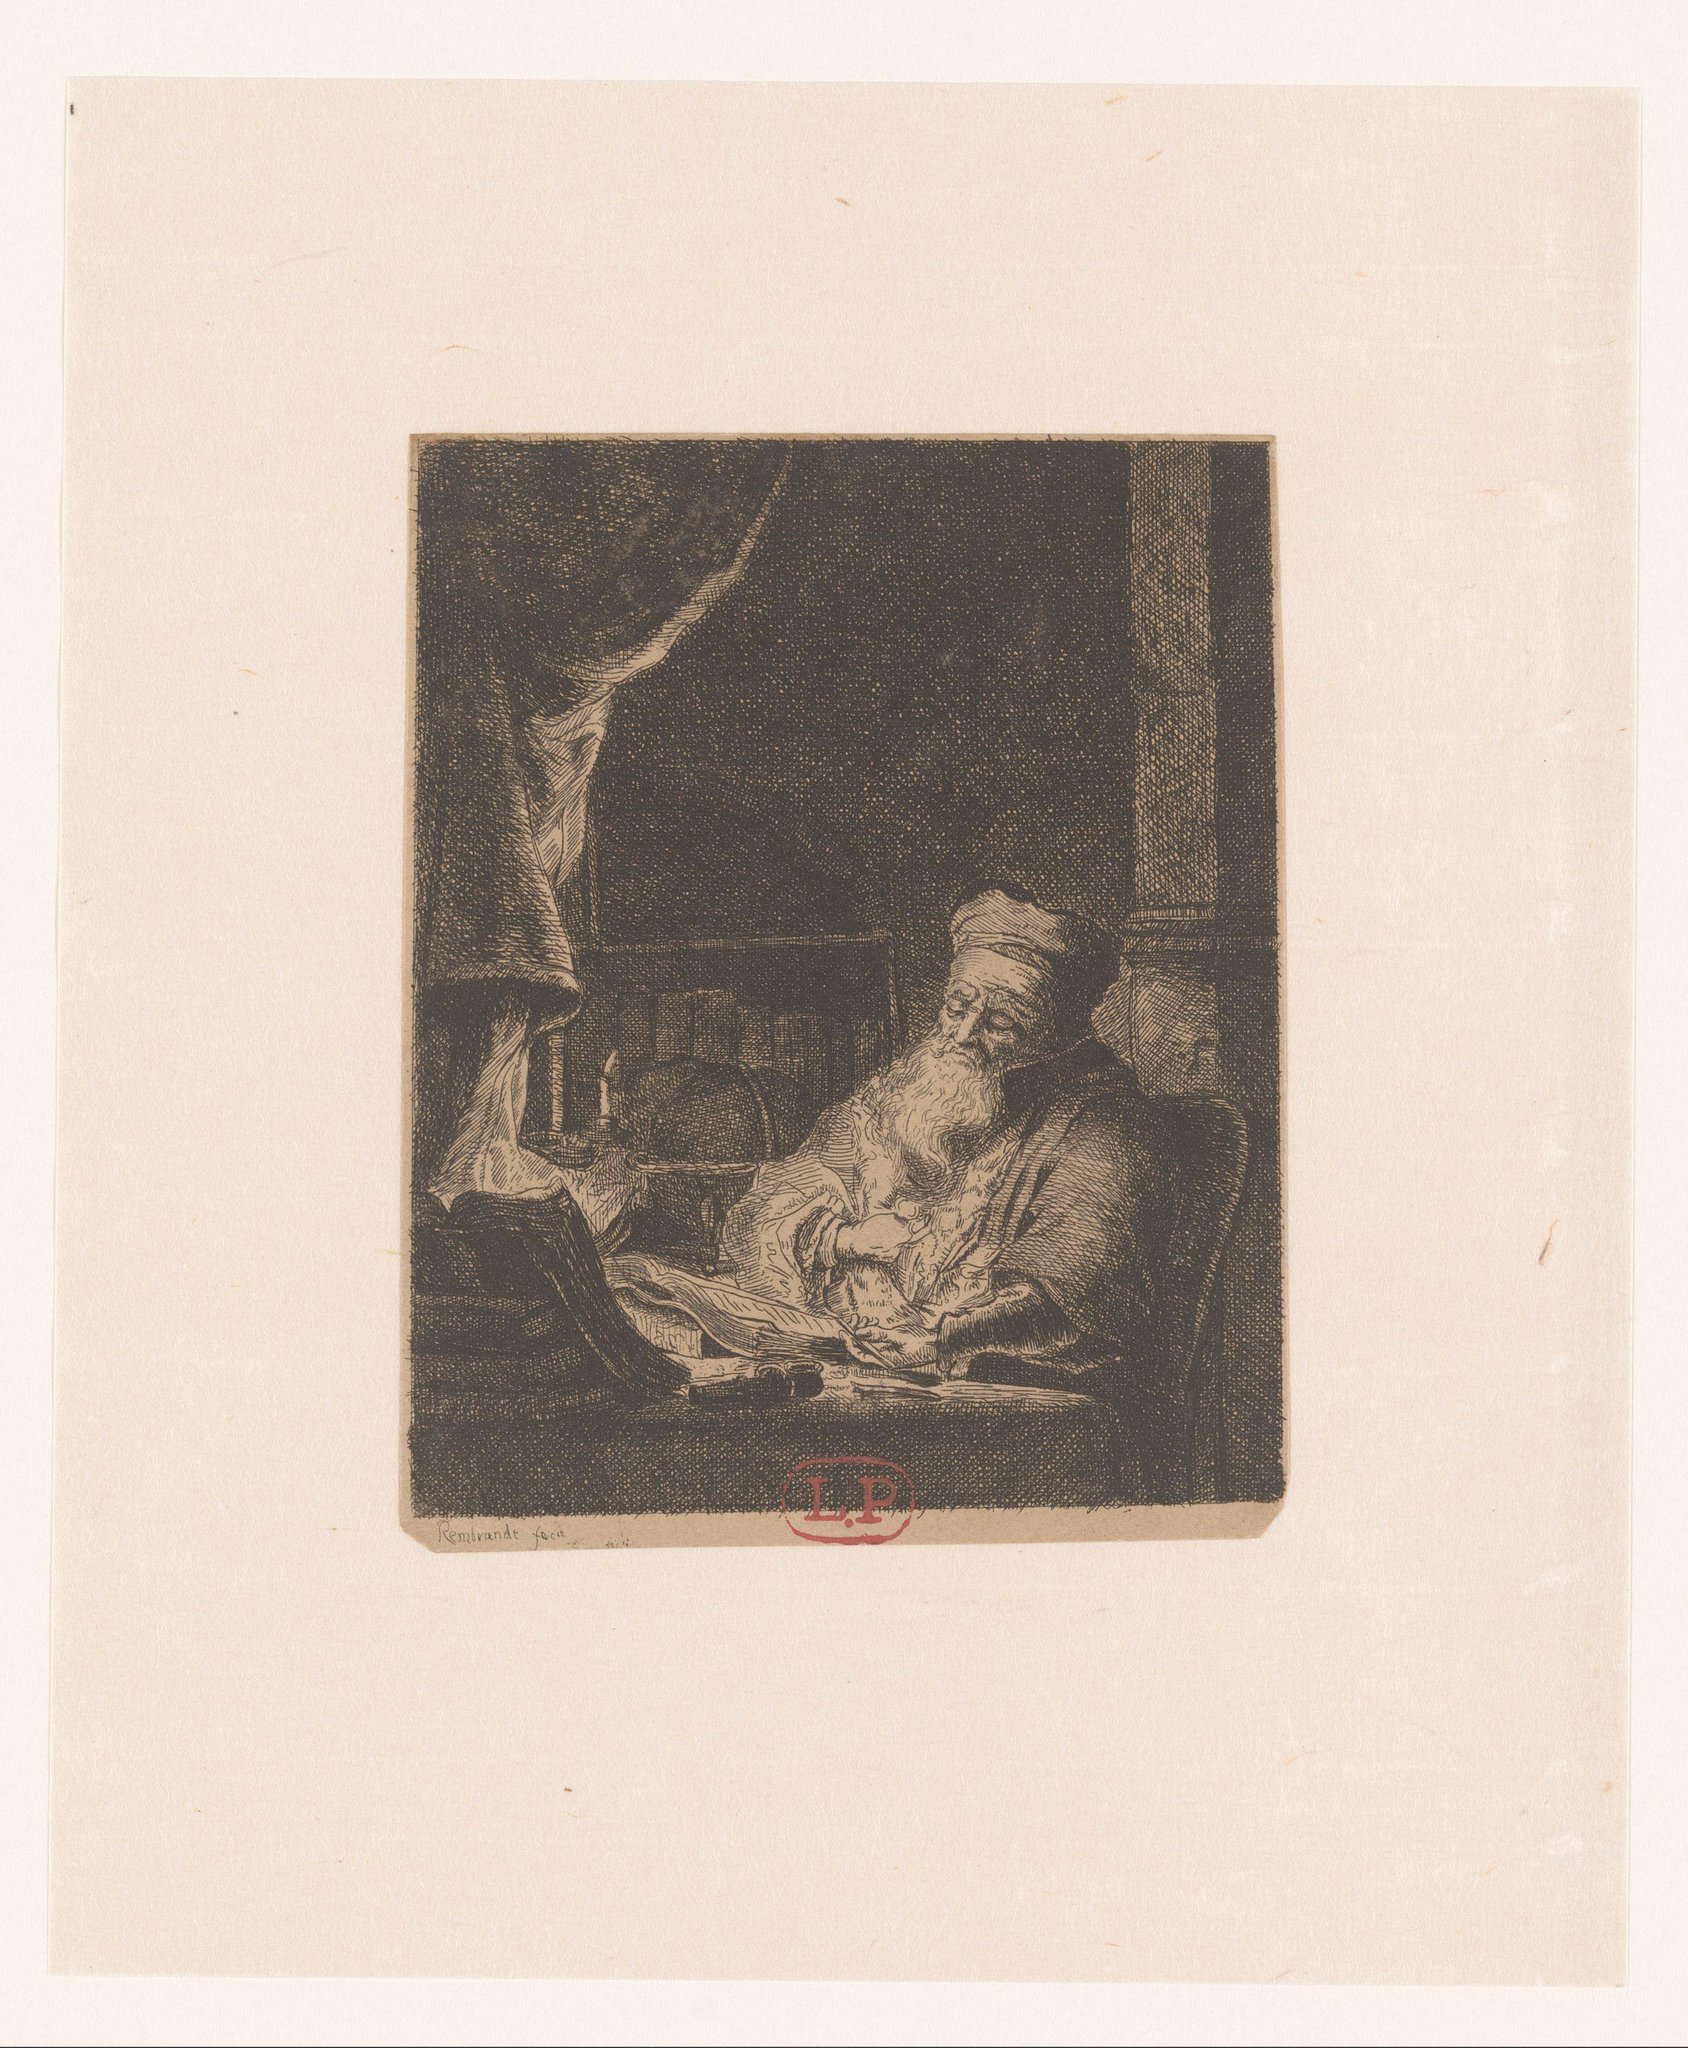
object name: print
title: Slapende filosoof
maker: monogrammist lp (frankrijk)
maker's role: print maker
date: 1800-1899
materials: paper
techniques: etching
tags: abstract ideas and concepts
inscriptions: collector's mark: Lugt 2228, collector's mark: Lugt 2760, stamp